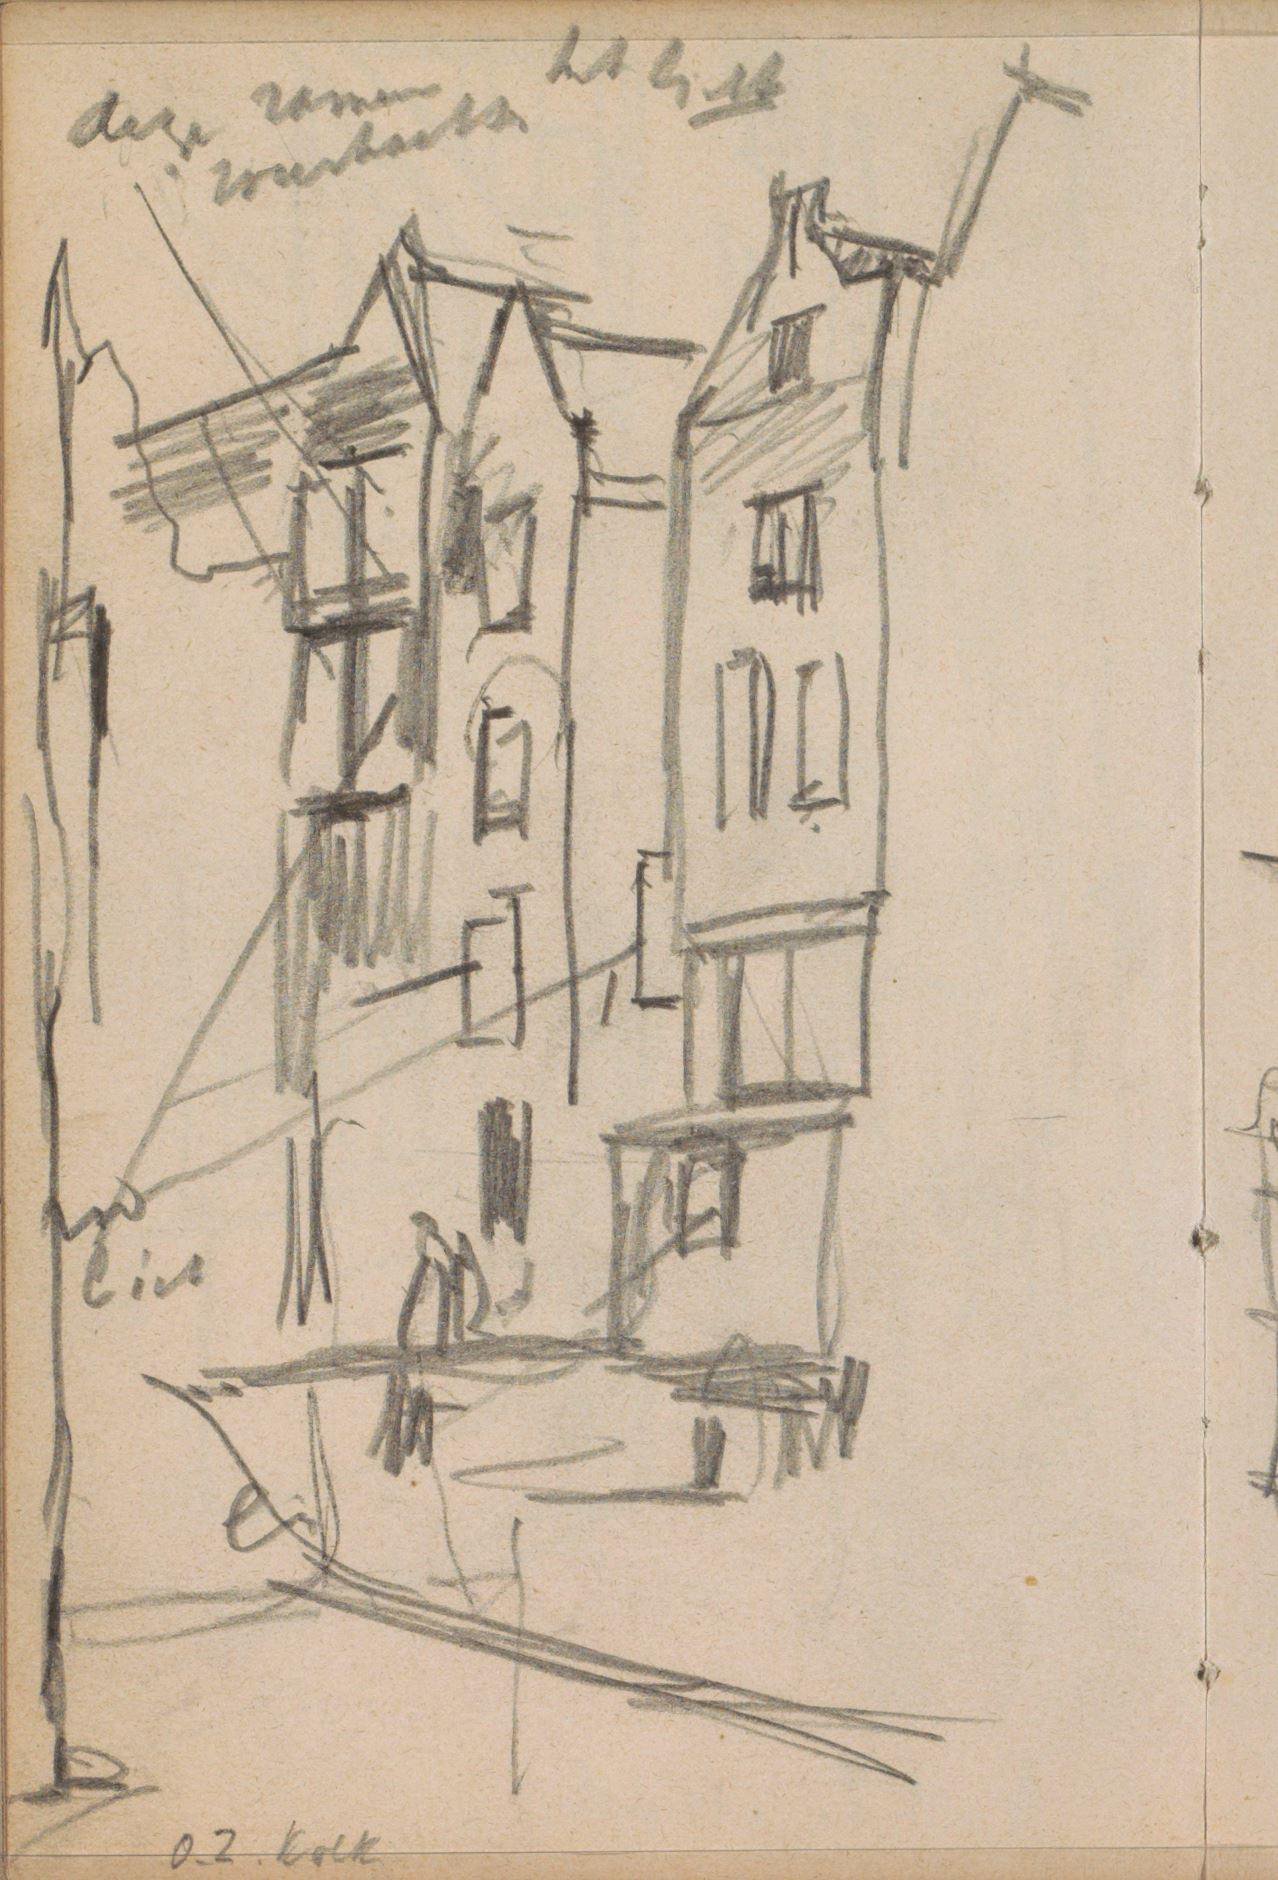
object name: sketchbook leaf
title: Gezicht op de Oudezijds Kolk te Amsterdam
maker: george hendrik breitner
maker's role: draughtsman, painter, print maker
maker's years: 1857-1923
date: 1902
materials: paper, pencil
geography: amsterdam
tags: urban housing, street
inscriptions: annotation: ‘deze ramen/ weerkaatsen het licht/ licht/ O.Z. Kolk’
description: Pagina 33 uit een schetsboek met 46 bladen vervaardigd in de omgeving van Amsterdam, Rotterdam en Haarlem.